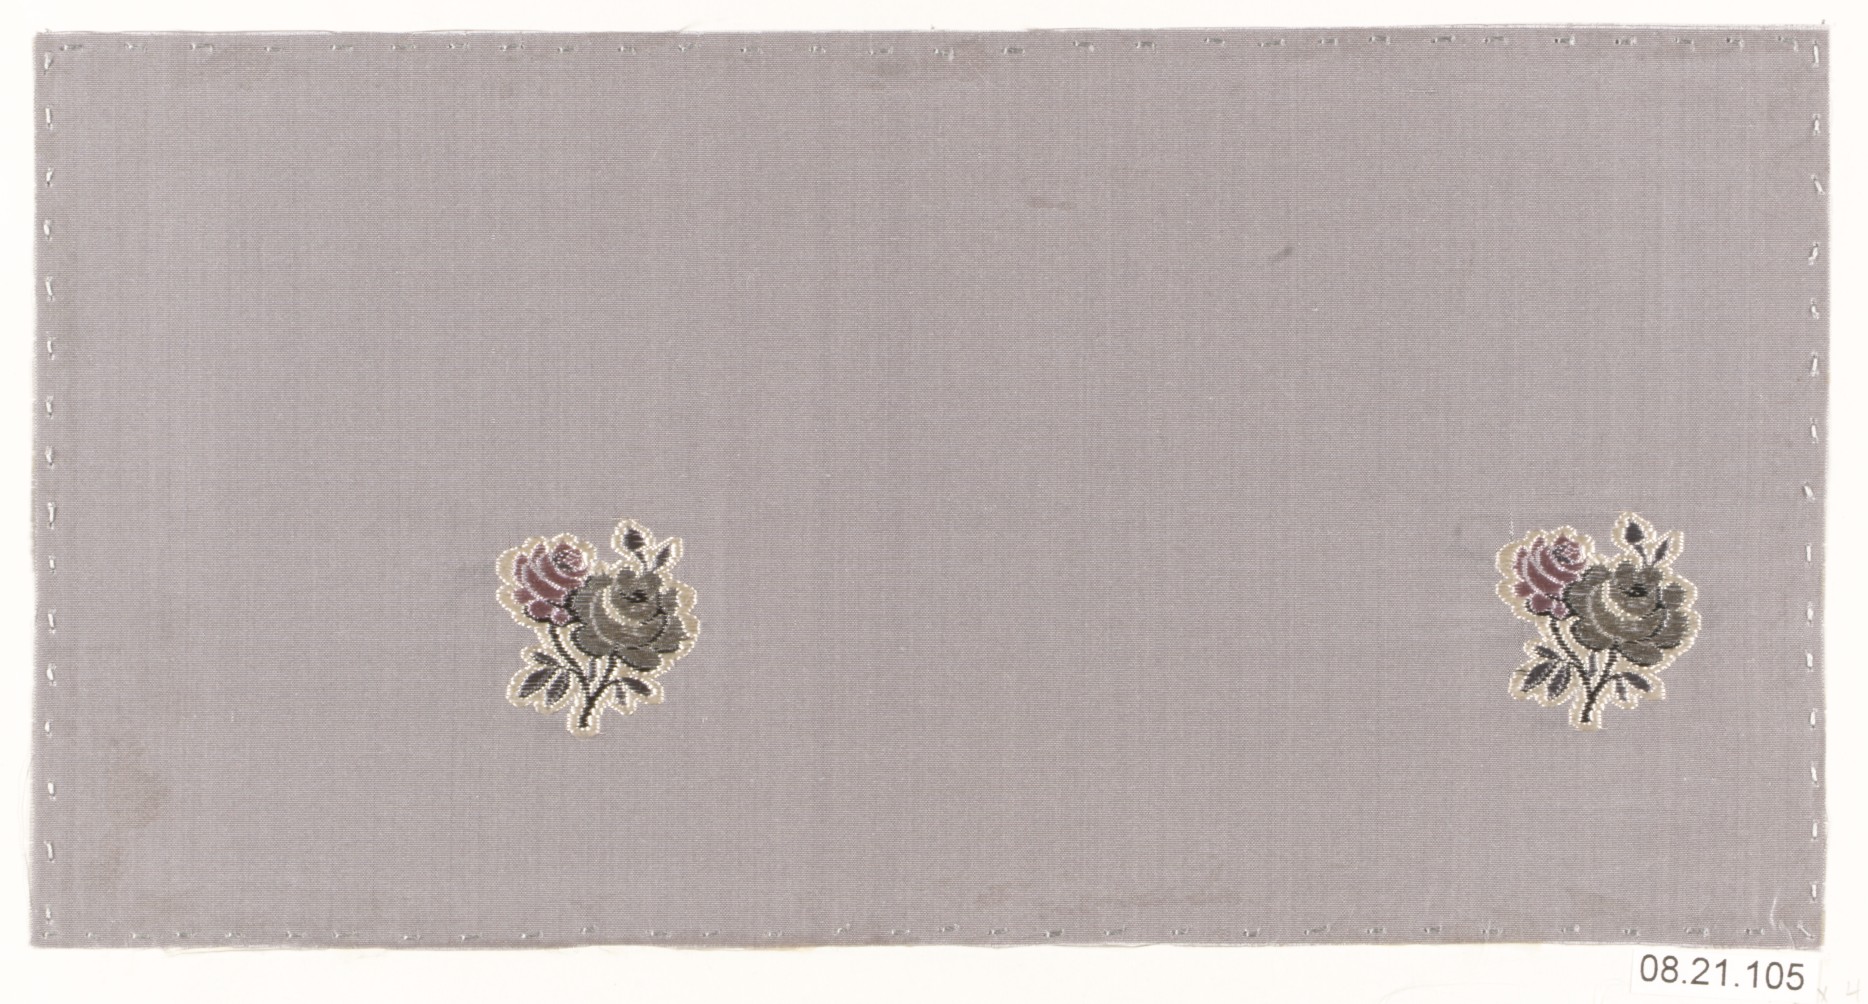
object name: textile sample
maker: Anonymous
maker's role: designer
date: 1900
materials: silk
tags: flowers